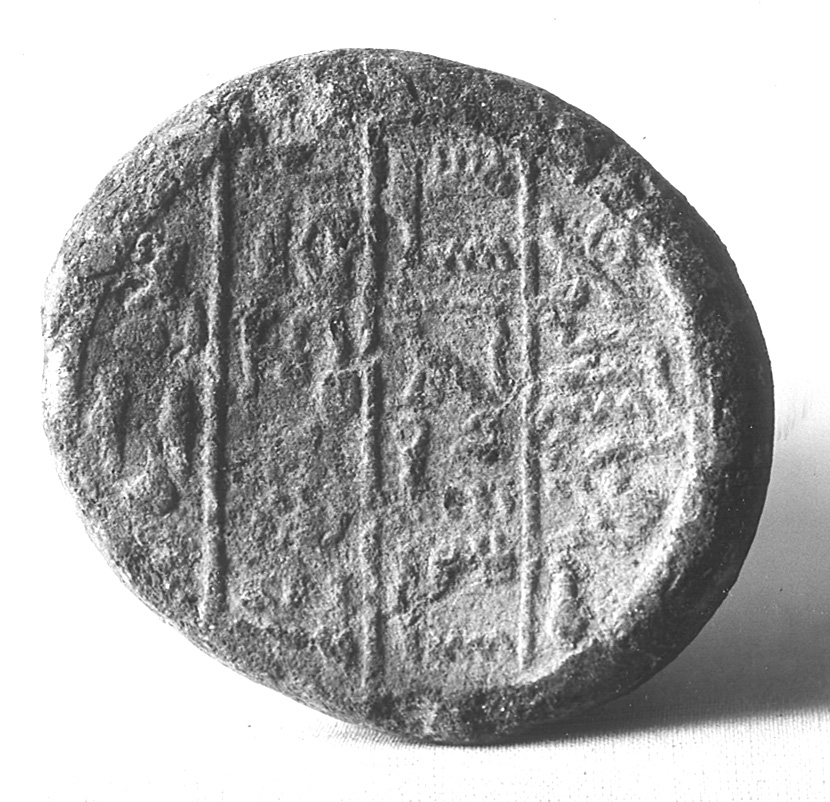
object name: cone, circular impression, amenemopet, tjanefer, scribe, amun, overseer, field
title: Funerary Cone of Amenemopet called Tjanefer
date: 1550-1352 BCE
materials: pottery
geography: egypt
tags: hieroglyphs